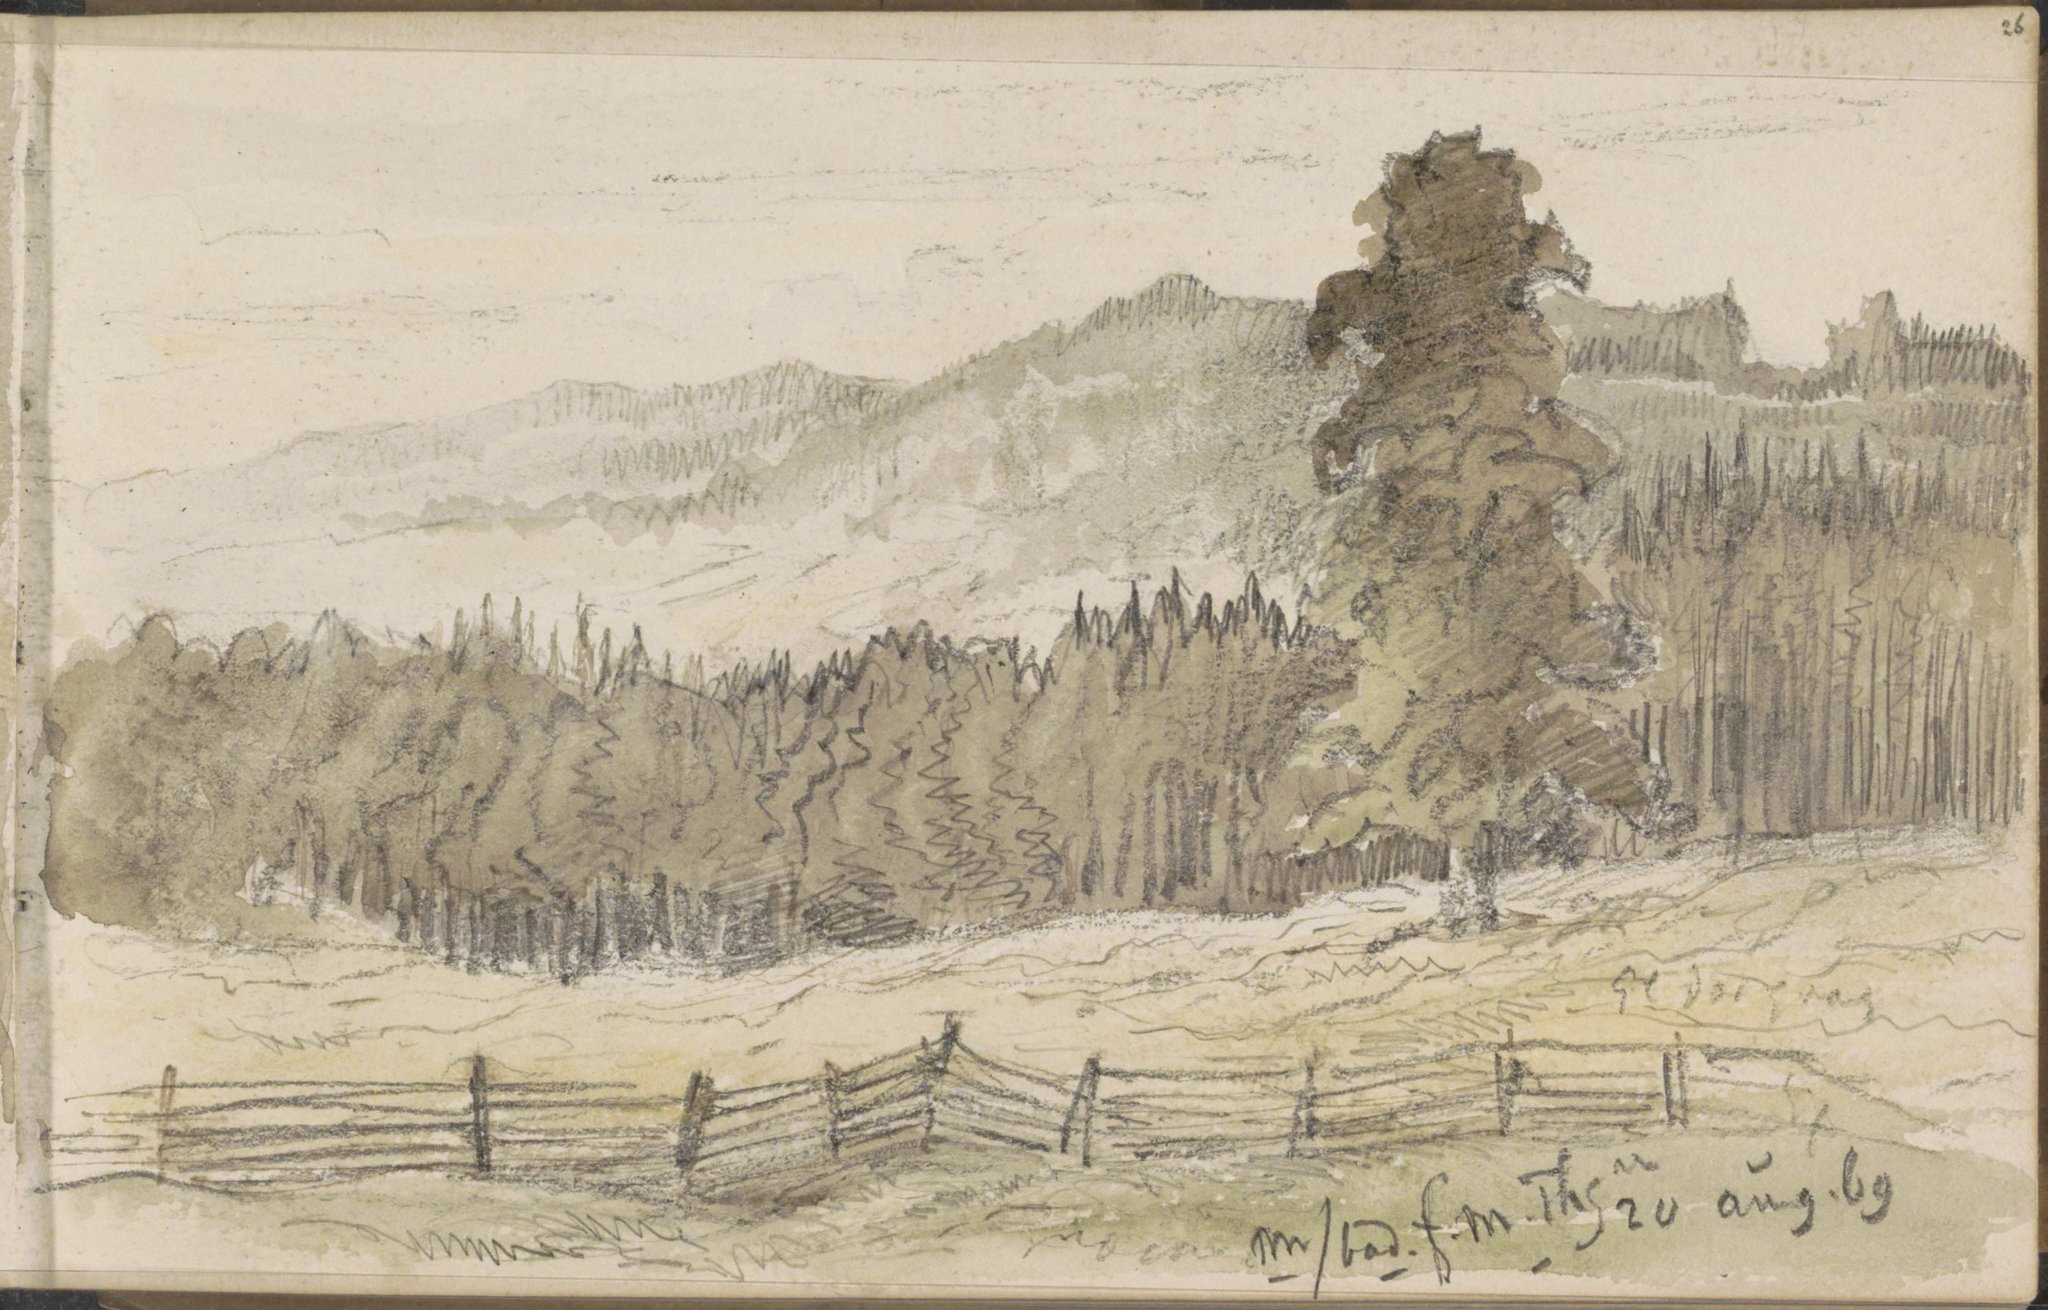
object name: sketchbook leaf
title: Bos aan de voet van een berg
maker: johannes tavenraat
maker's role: draughtsman, painter, print maker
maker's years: 1809-1881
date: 1808-1869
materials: ink, paper, pencil, watercolor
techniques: brush, pen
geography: marienbad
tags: fence, wall, paling, forest, wood, mountains, marienbad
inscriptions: date and inscription: ‘M/bad f.m. Th[...] 20 aug 69’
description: Blad 26 recto uit een schetsboek met 48 bladen.